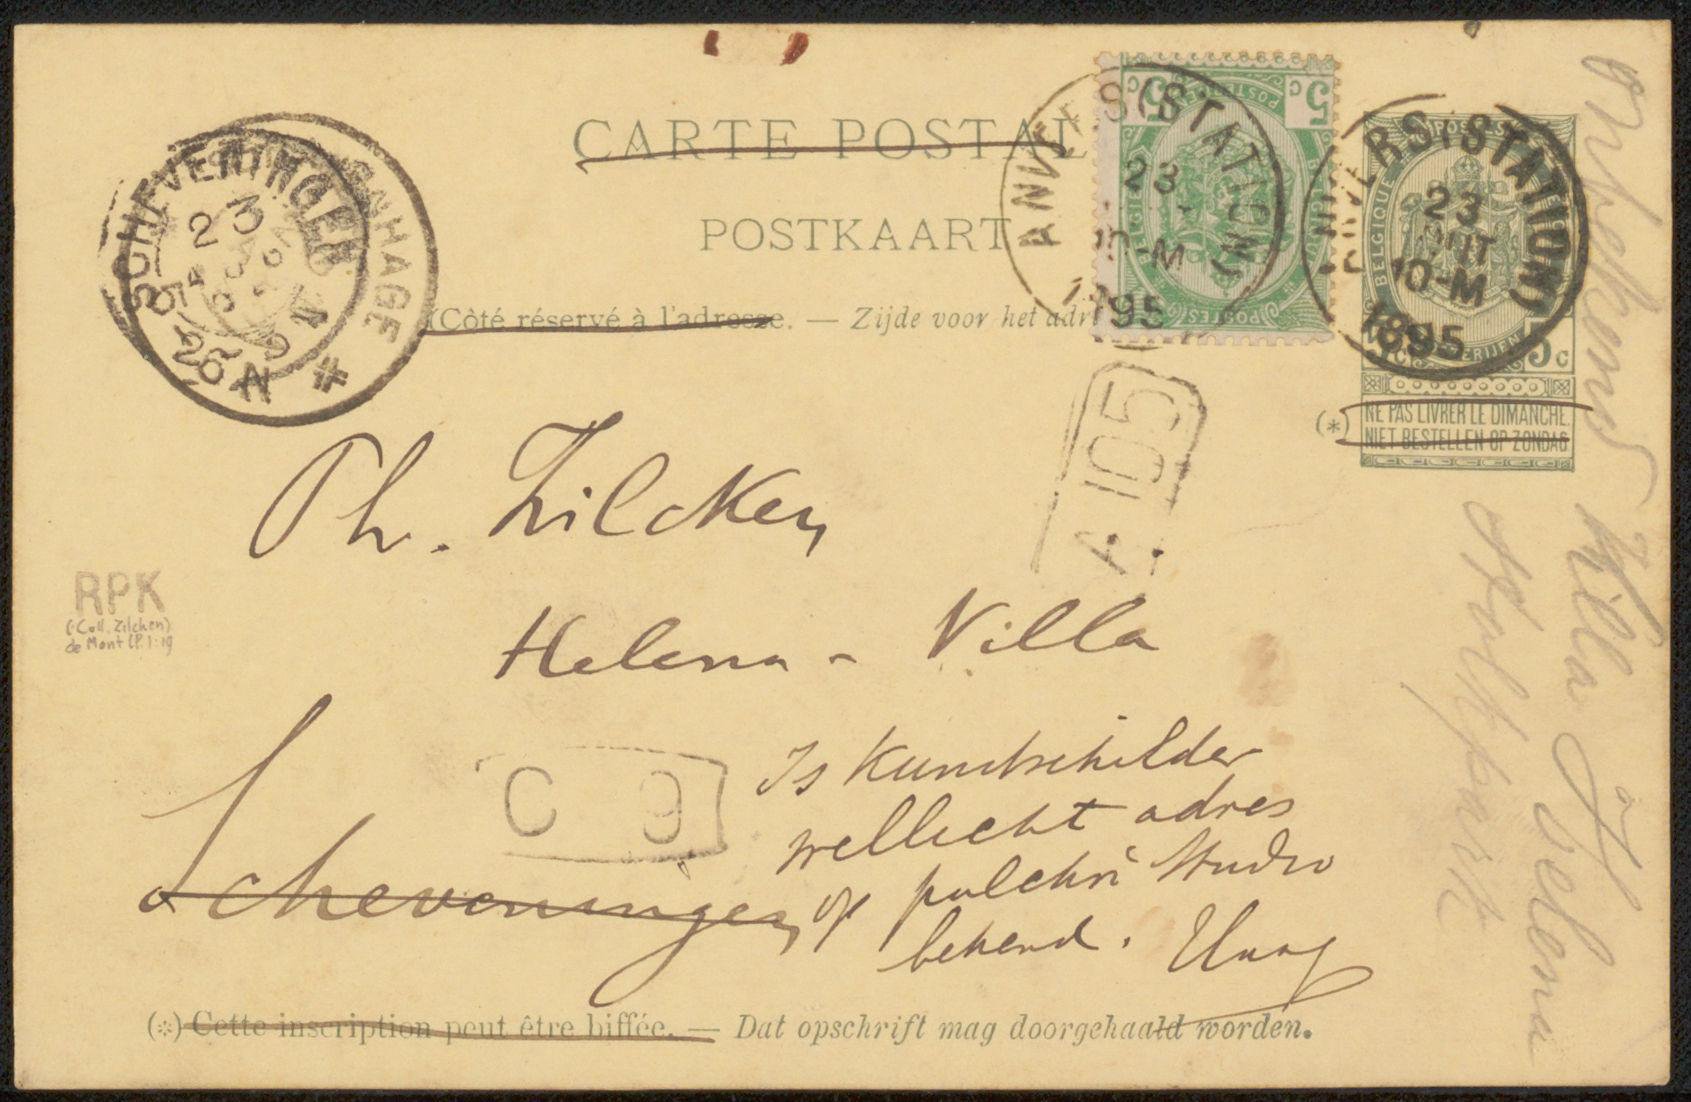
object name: postcard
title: Briefkaart aan Philip Zilcken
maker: pol de mont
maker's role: dichter, prozaschrijver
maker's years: 1857-1931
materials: cardboard, ink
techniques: pen, writing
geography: antwerp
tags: dordrecht, amsterdam, designer, jan veth, the hague, painter, print maker, draughtsman, theo van hoytema, willem wenckebach, jan toorop, richard nicolaüs roland holst, baronne madeleine deslandes, julius meier-graefe, philip zilcken, netherlands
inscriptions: collector's mark: ‘RPK’